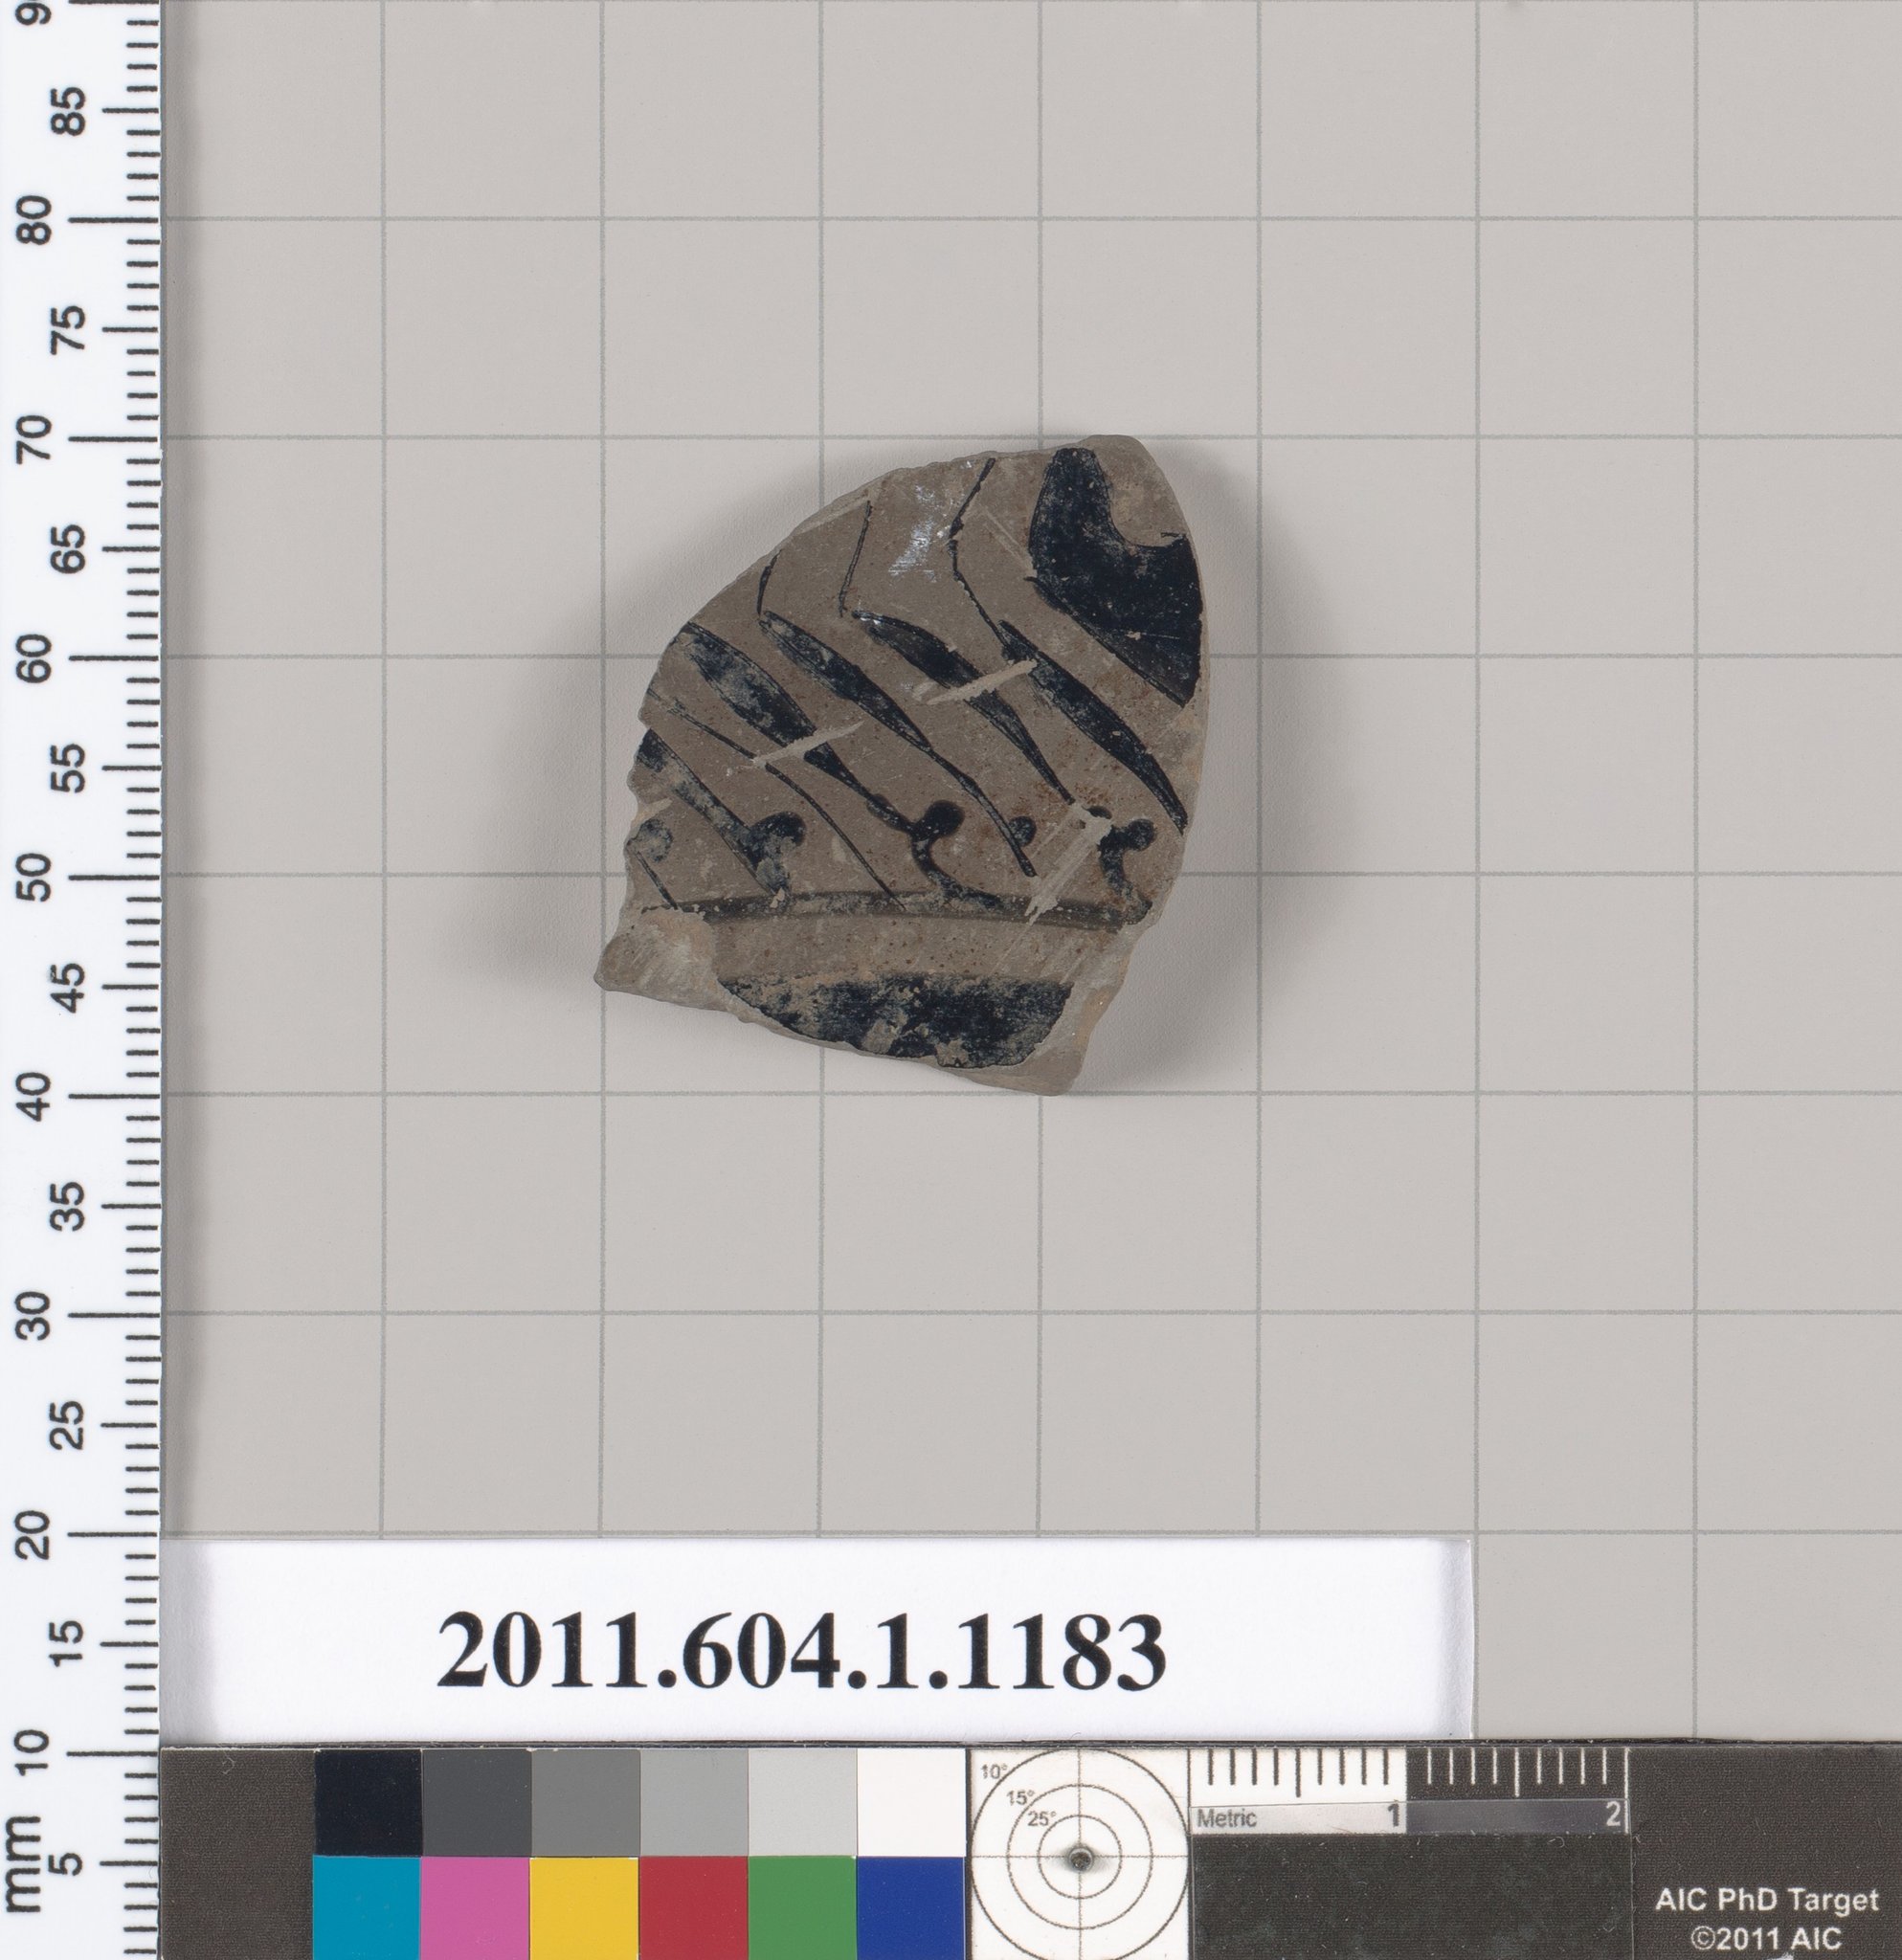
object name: kylix fragment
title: Terracotta fragment of a kylix (drinking cup)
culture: greek, attic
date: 475-451 BCE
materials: terracotta